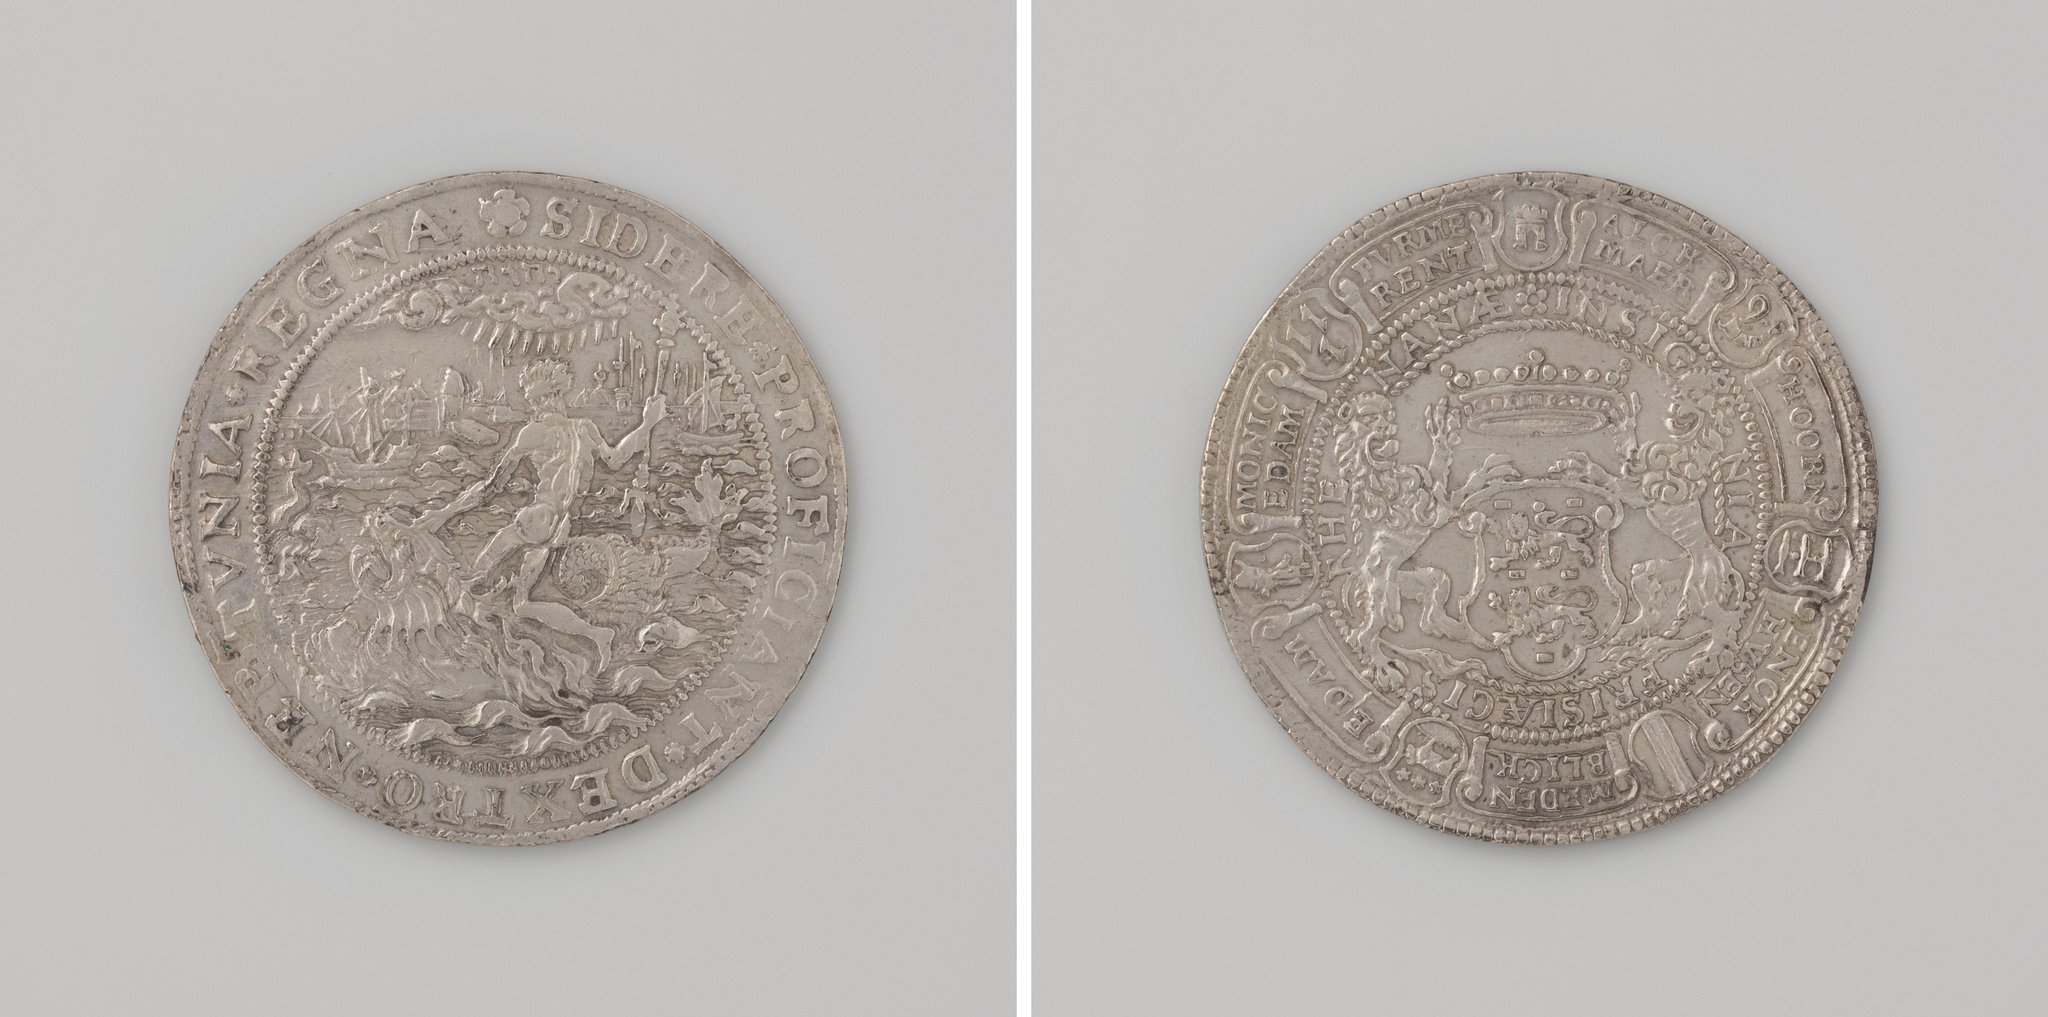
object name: history medal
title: Expansie van de zeevaart in de Westfriese steden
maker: paulus van wtewael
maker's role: die cutter, draughtsman, print maker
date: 1596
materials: silver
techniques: striking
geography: west frisia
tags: west-friesland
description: Zilveren penning. Voorzijde: Neptunus met drietand gezeten op watermonster, op achtergrond schepen en stad binnen omschrift. Keerzijde: door twee leeuwen bekroond wapenschild binnen omschrift en rand met namen.